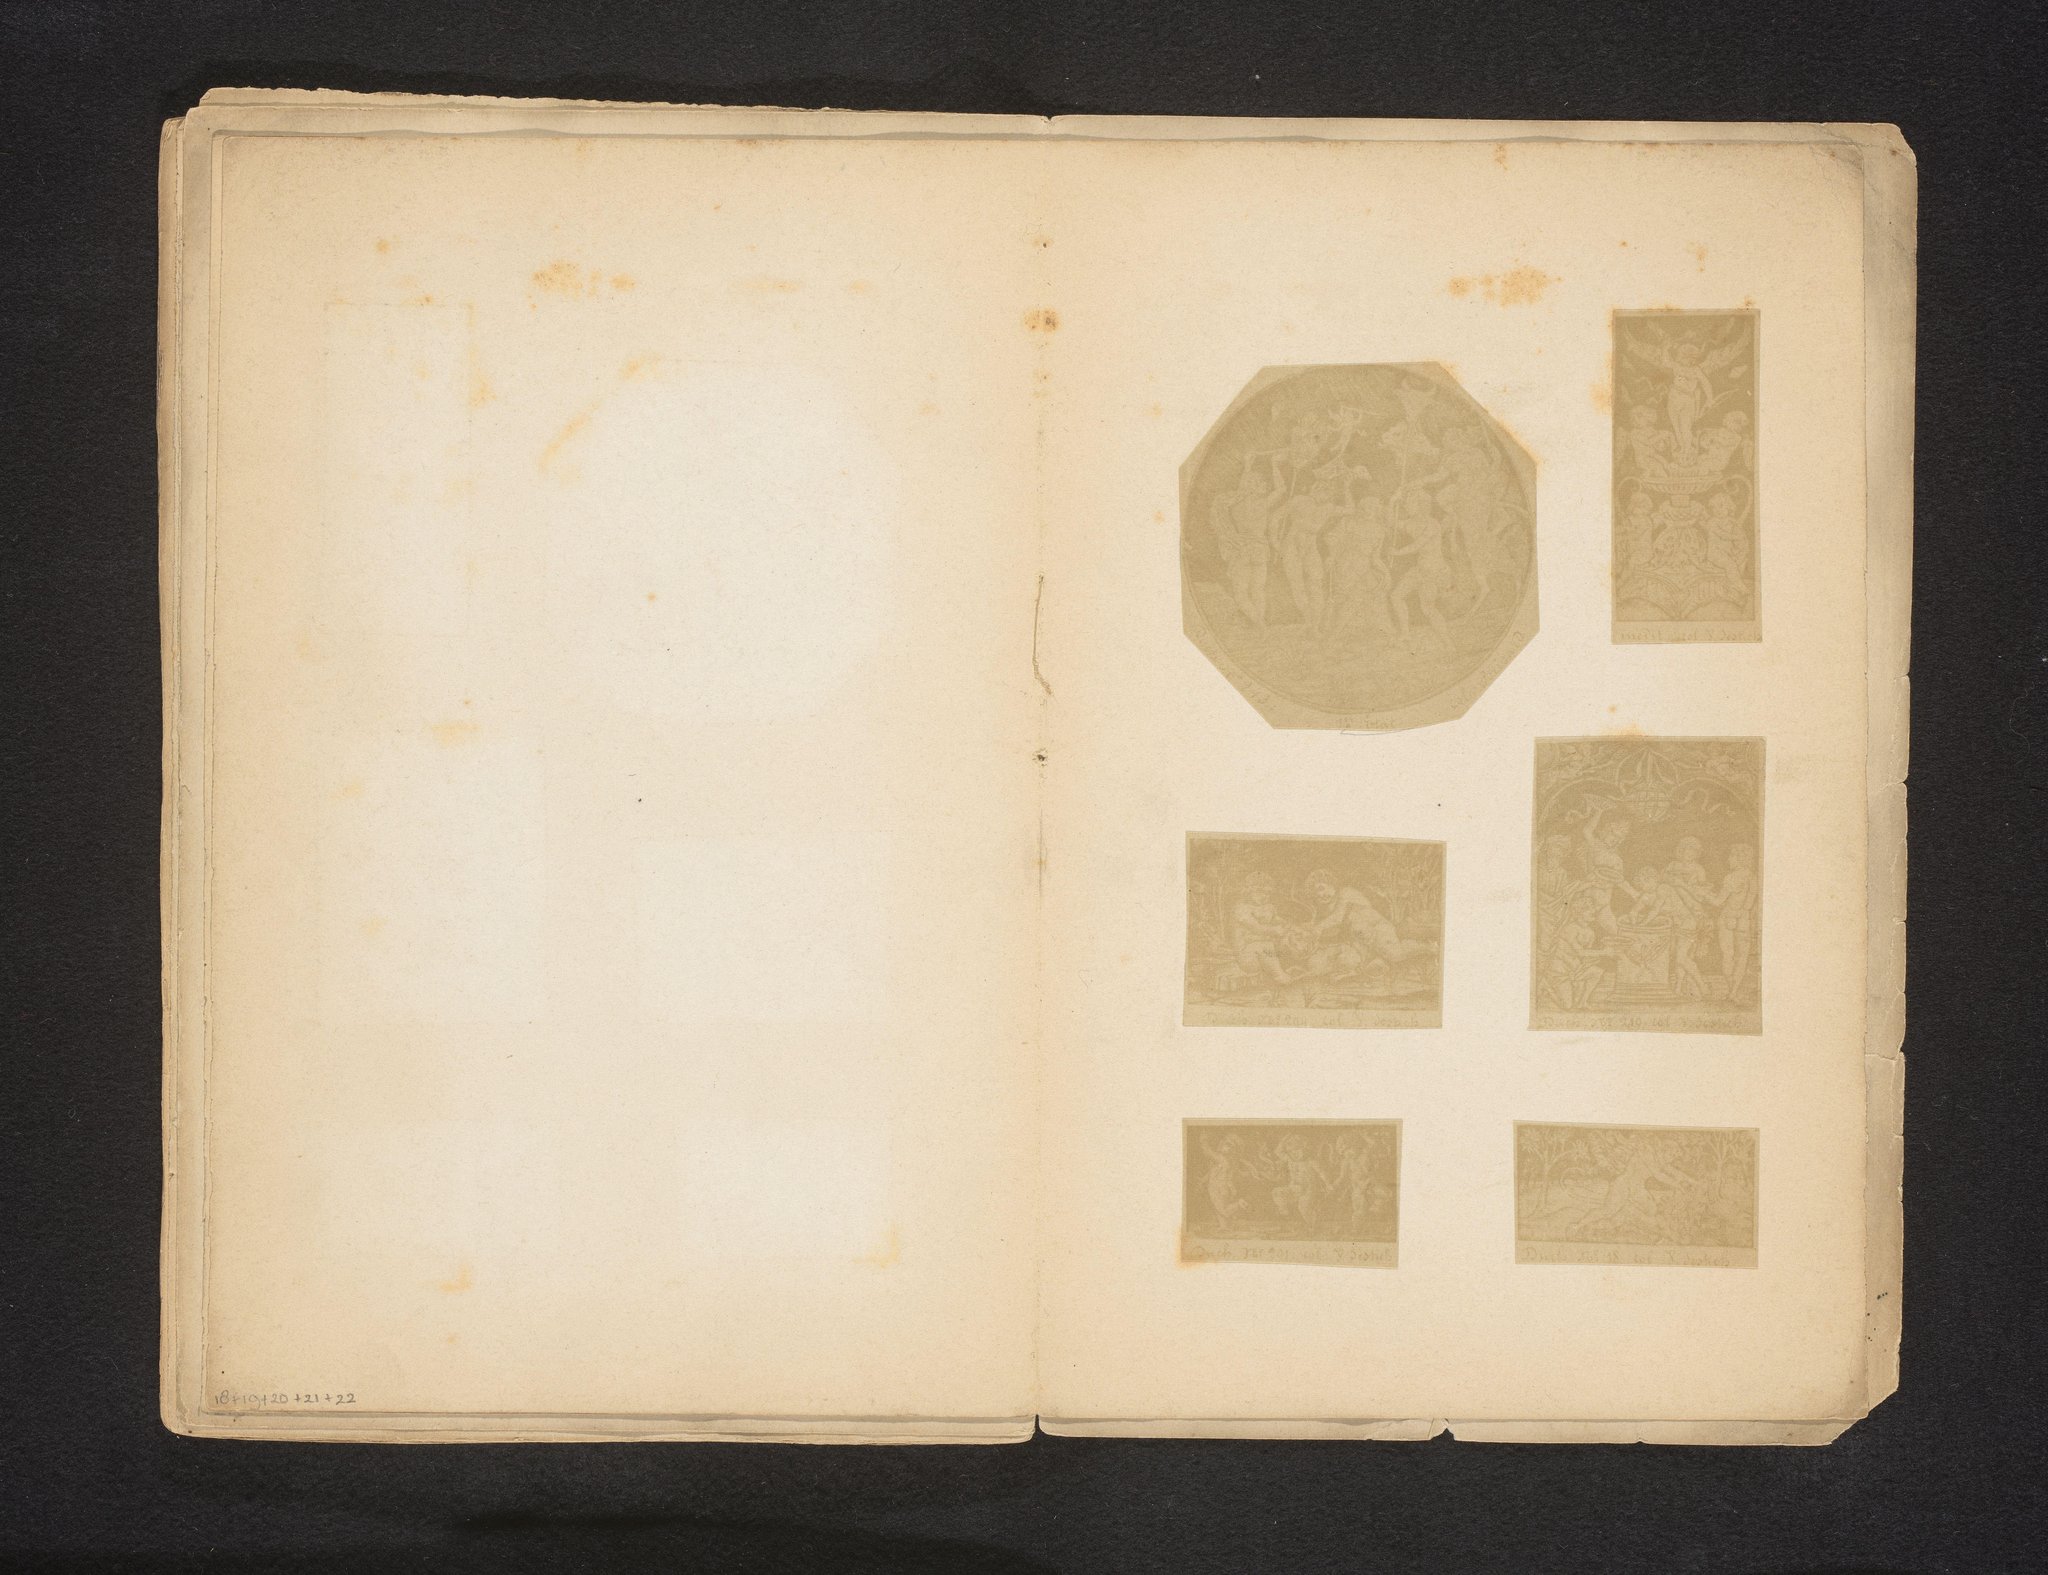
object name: photograph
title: Fotoreproductie van een prent van twee kinderen die met een hond spelen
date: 1852-1857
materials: photographic support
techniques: salted paper print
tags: child, dog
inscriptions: inscription: ‘Duch. No 294. Col. V. Sestich’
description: Foto op blad met zes foto's op negende ongenummerde pagina na pagina 60.